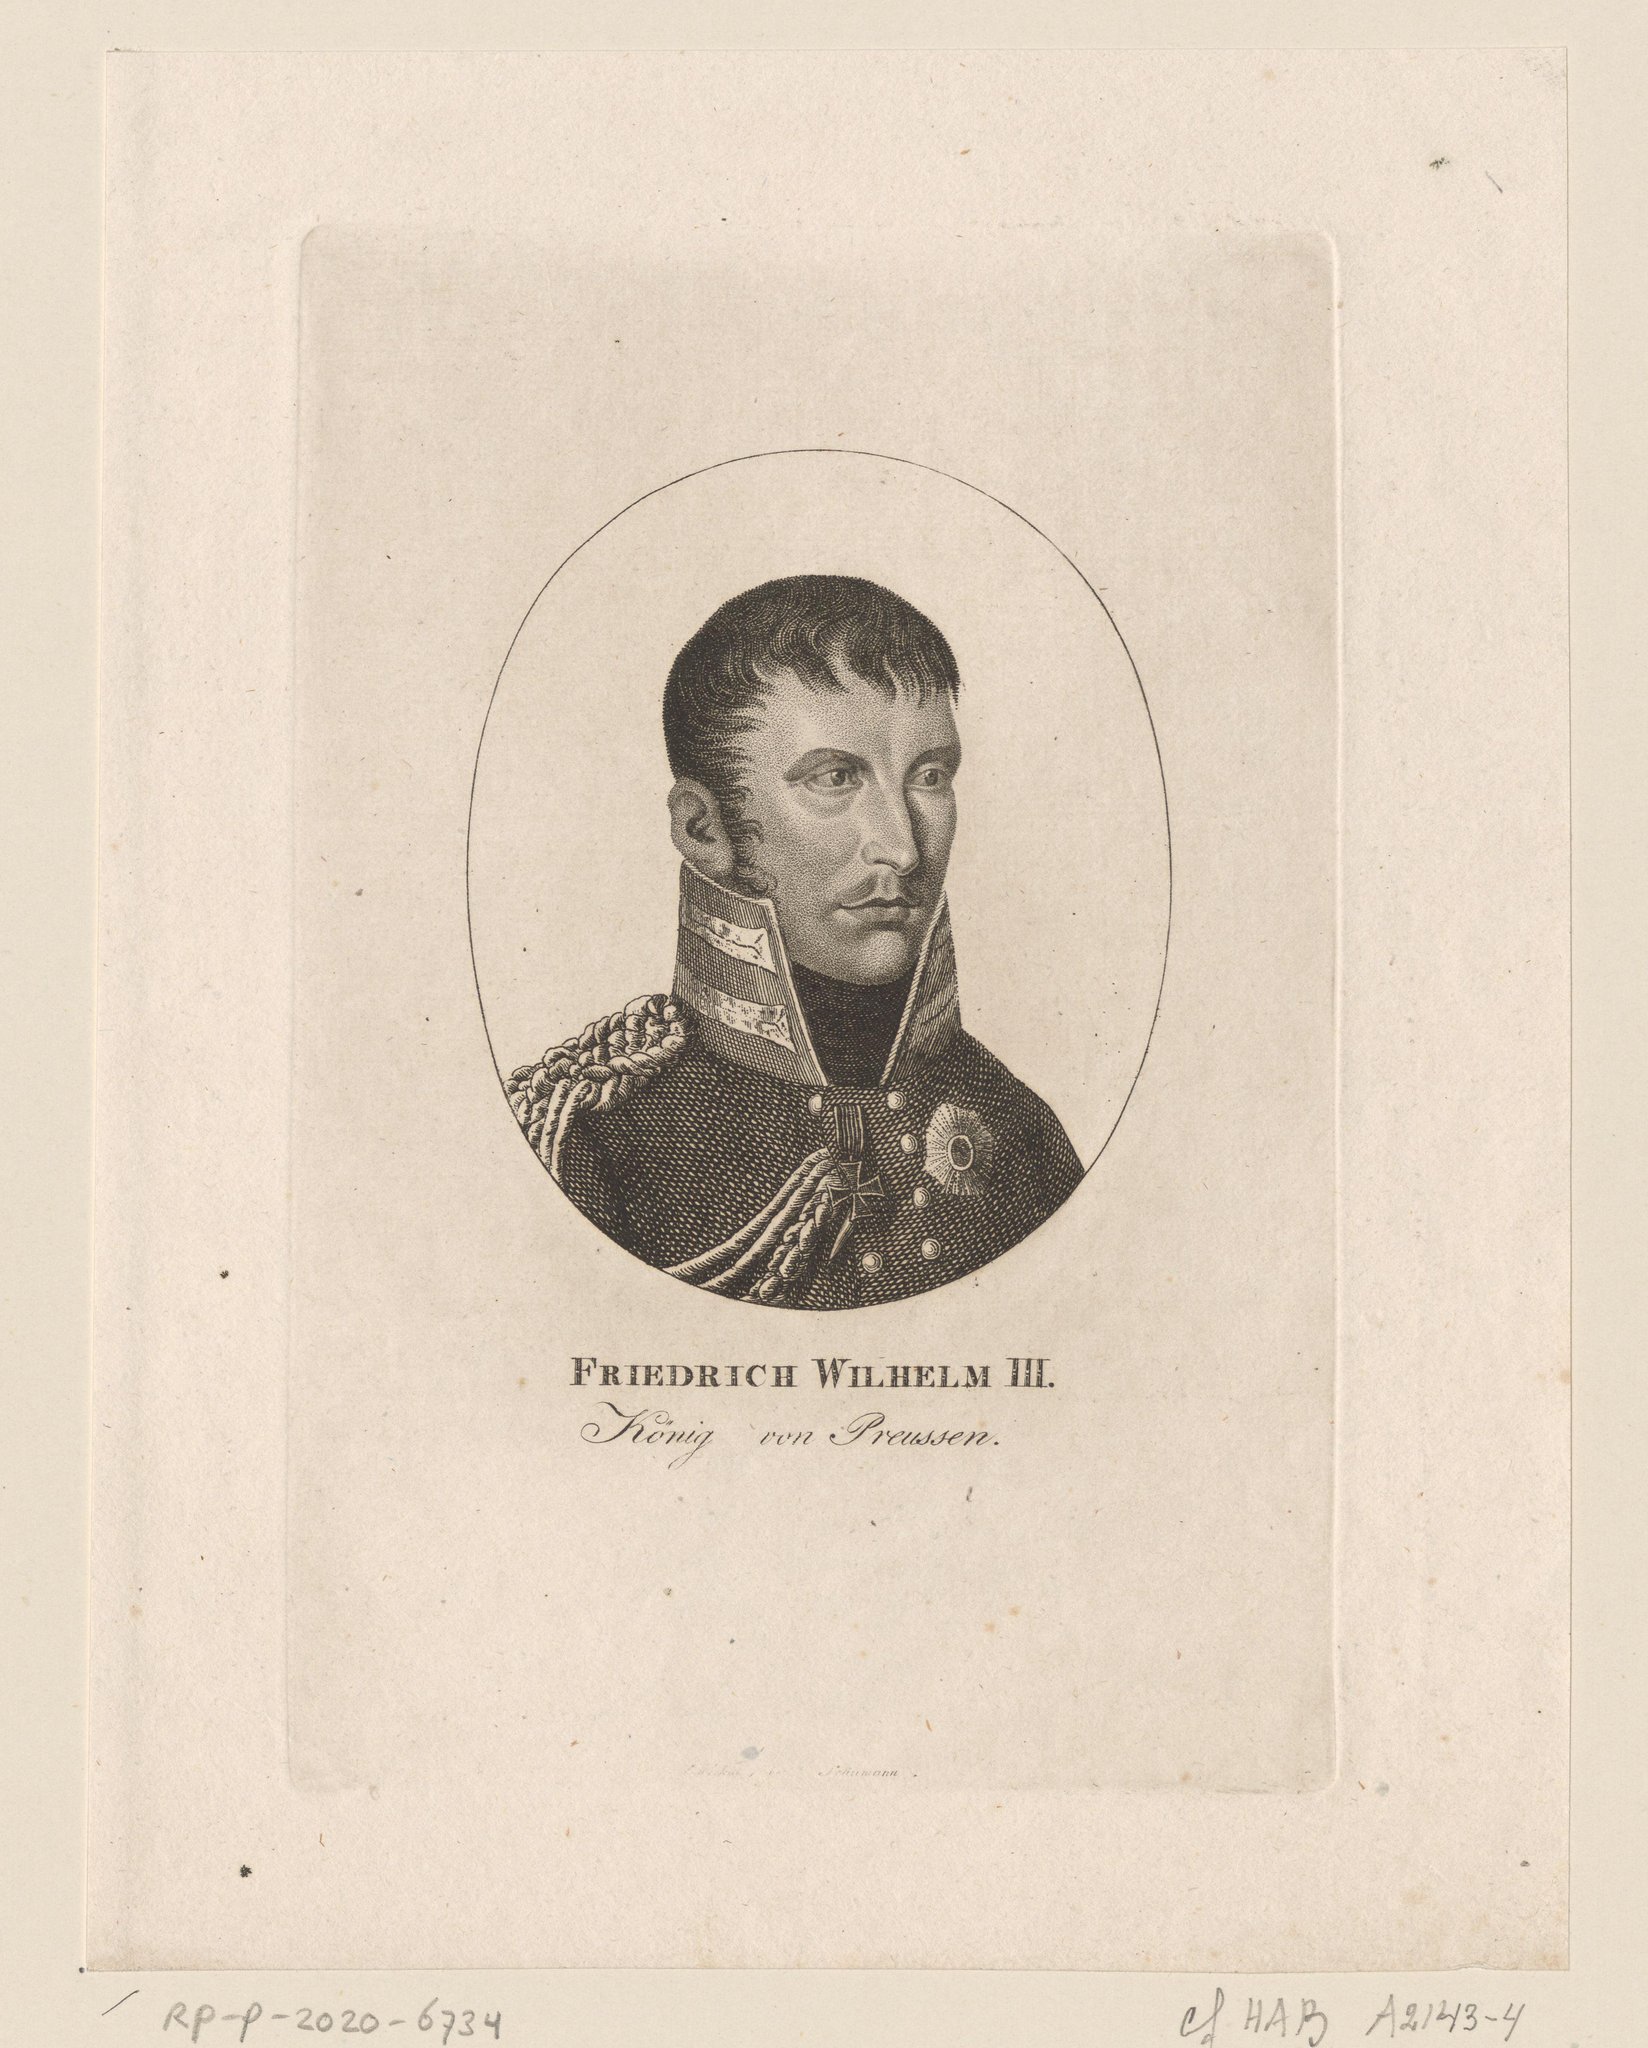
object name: print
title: Portret van Frederik Willem III van Pruisen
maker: Anonymous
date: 1804-1843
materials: paper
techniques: etching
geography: germany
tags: berlin, frederik willem iii koning van pruisen, historical persons, (military) uniforms, king